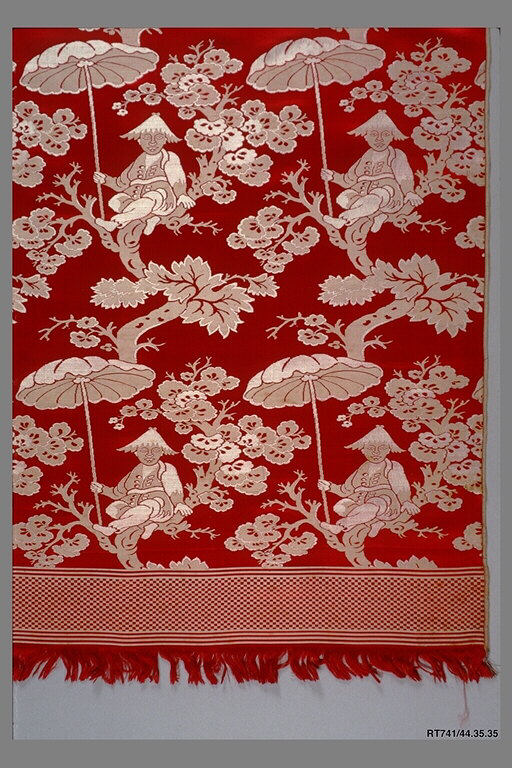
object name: length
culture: chinese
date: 1901-1933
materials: silk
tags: men,trees,parasols